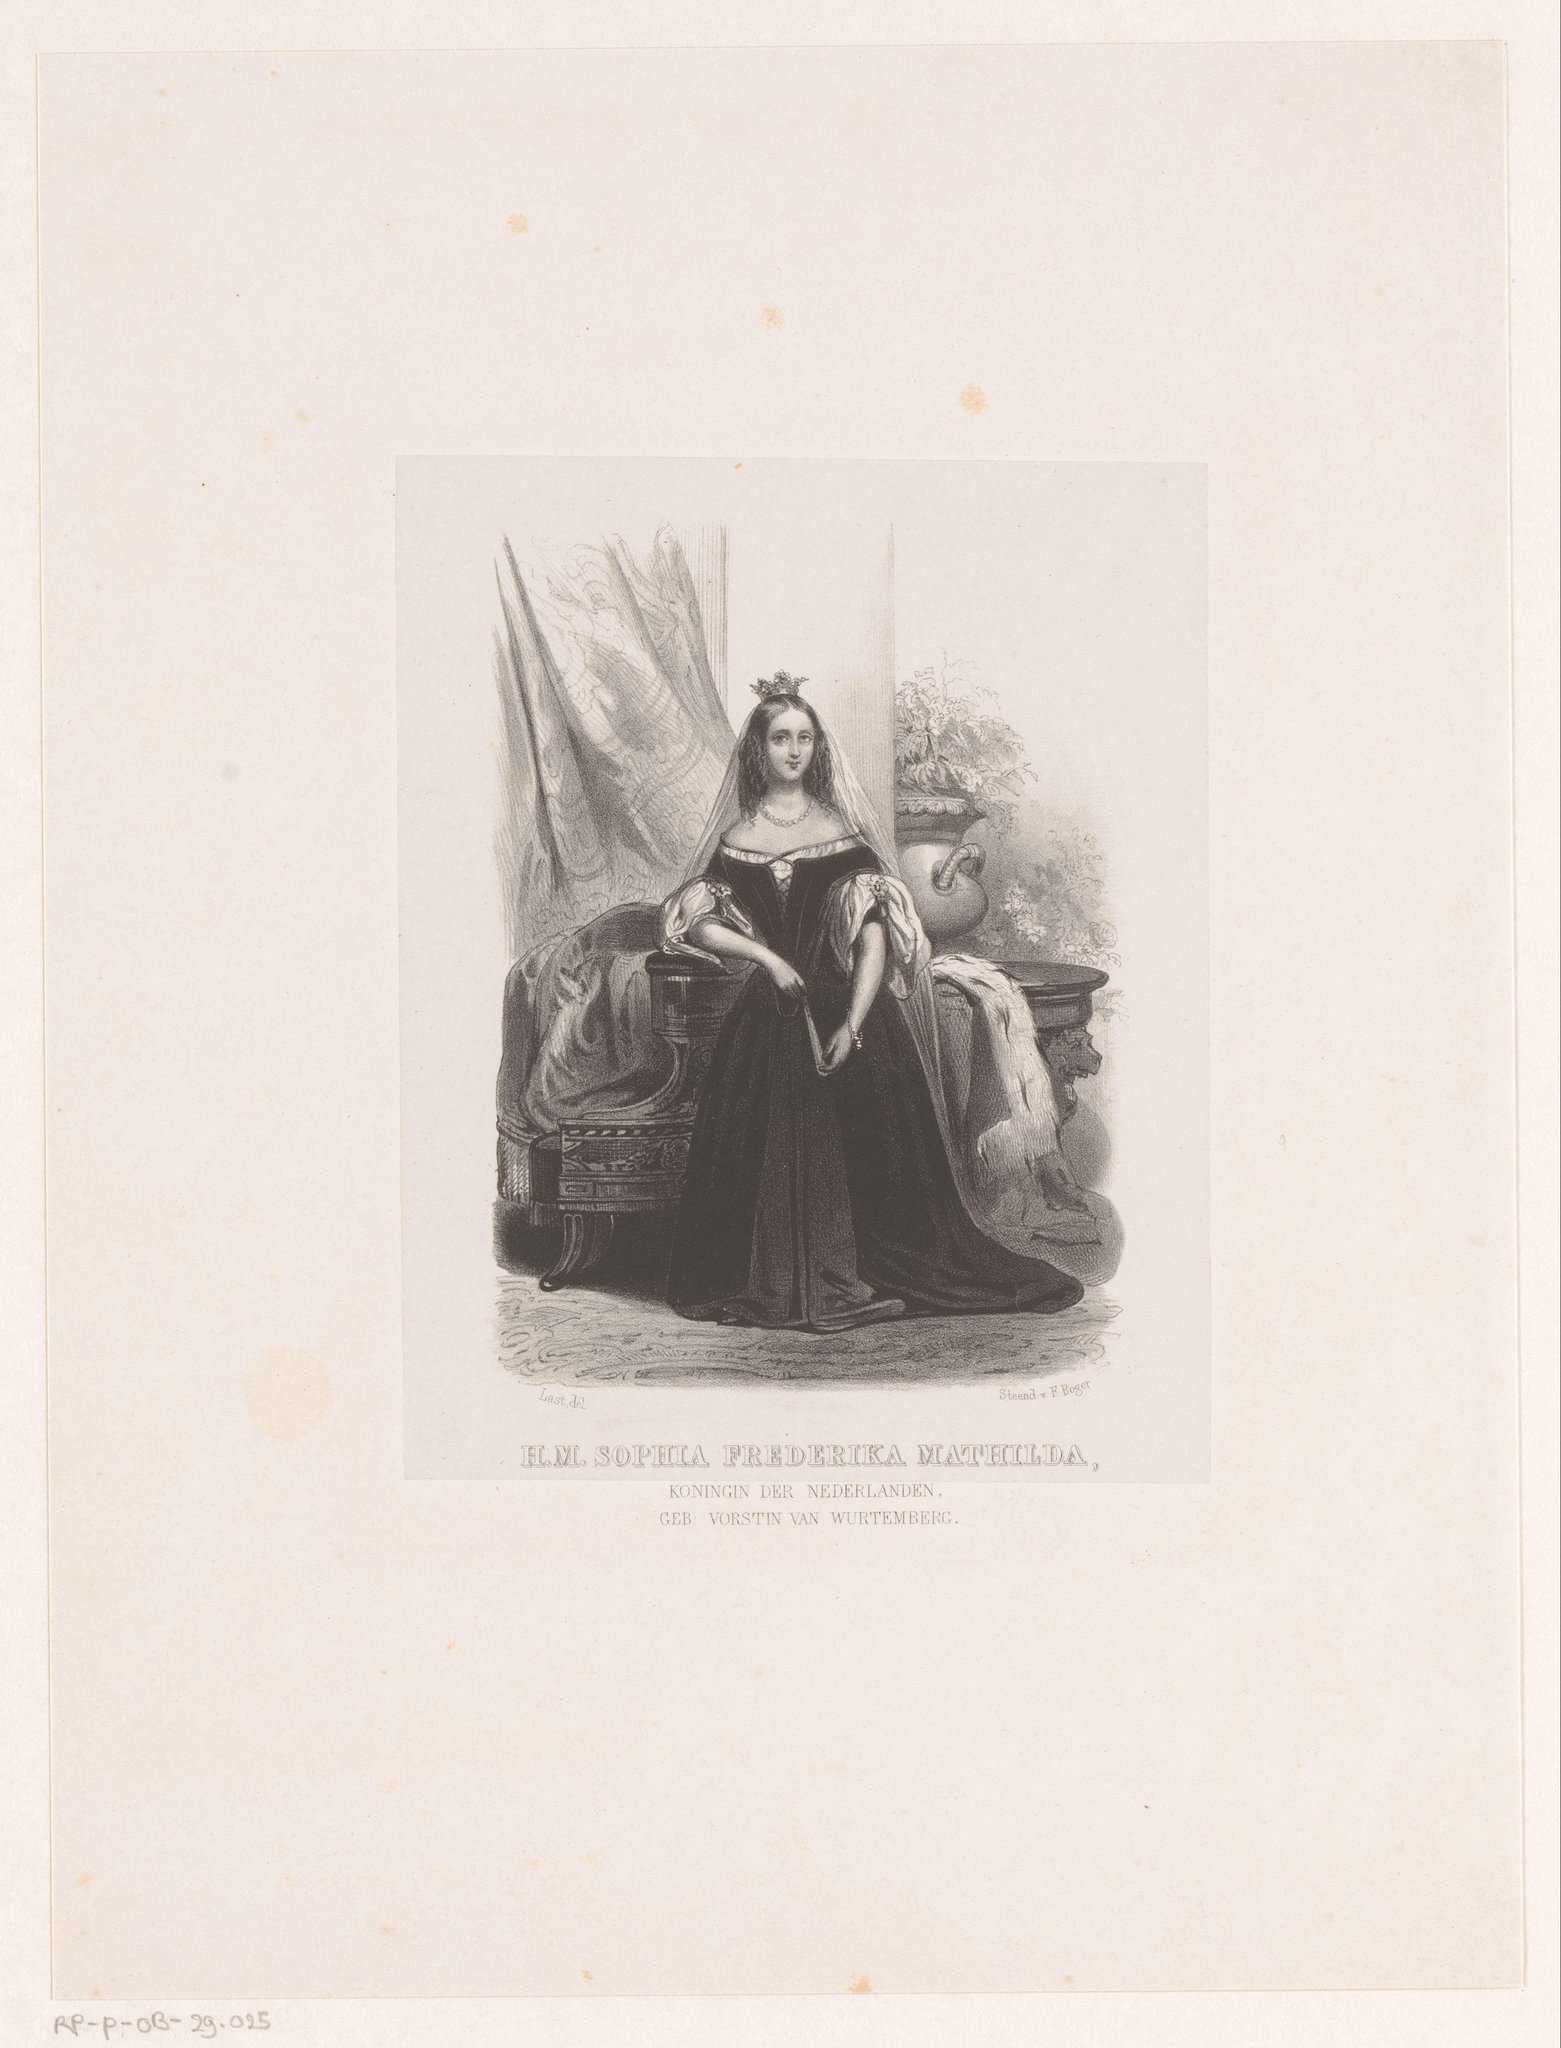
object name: print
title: Portret van Sophie van Württemberg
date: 1846-1876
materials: paper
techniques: lithograph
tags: the hague, sophia frederika mathilda van württemberg, fan, historical persons - bb - woman (+ full length portrait)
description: De geportretteerde staat voor een tafel, een draperie en een vaas met bloemen. Op haar hoofd draagt zij een kroon en een sluier. In haar handen heeft zij een ingeklapte waaier.